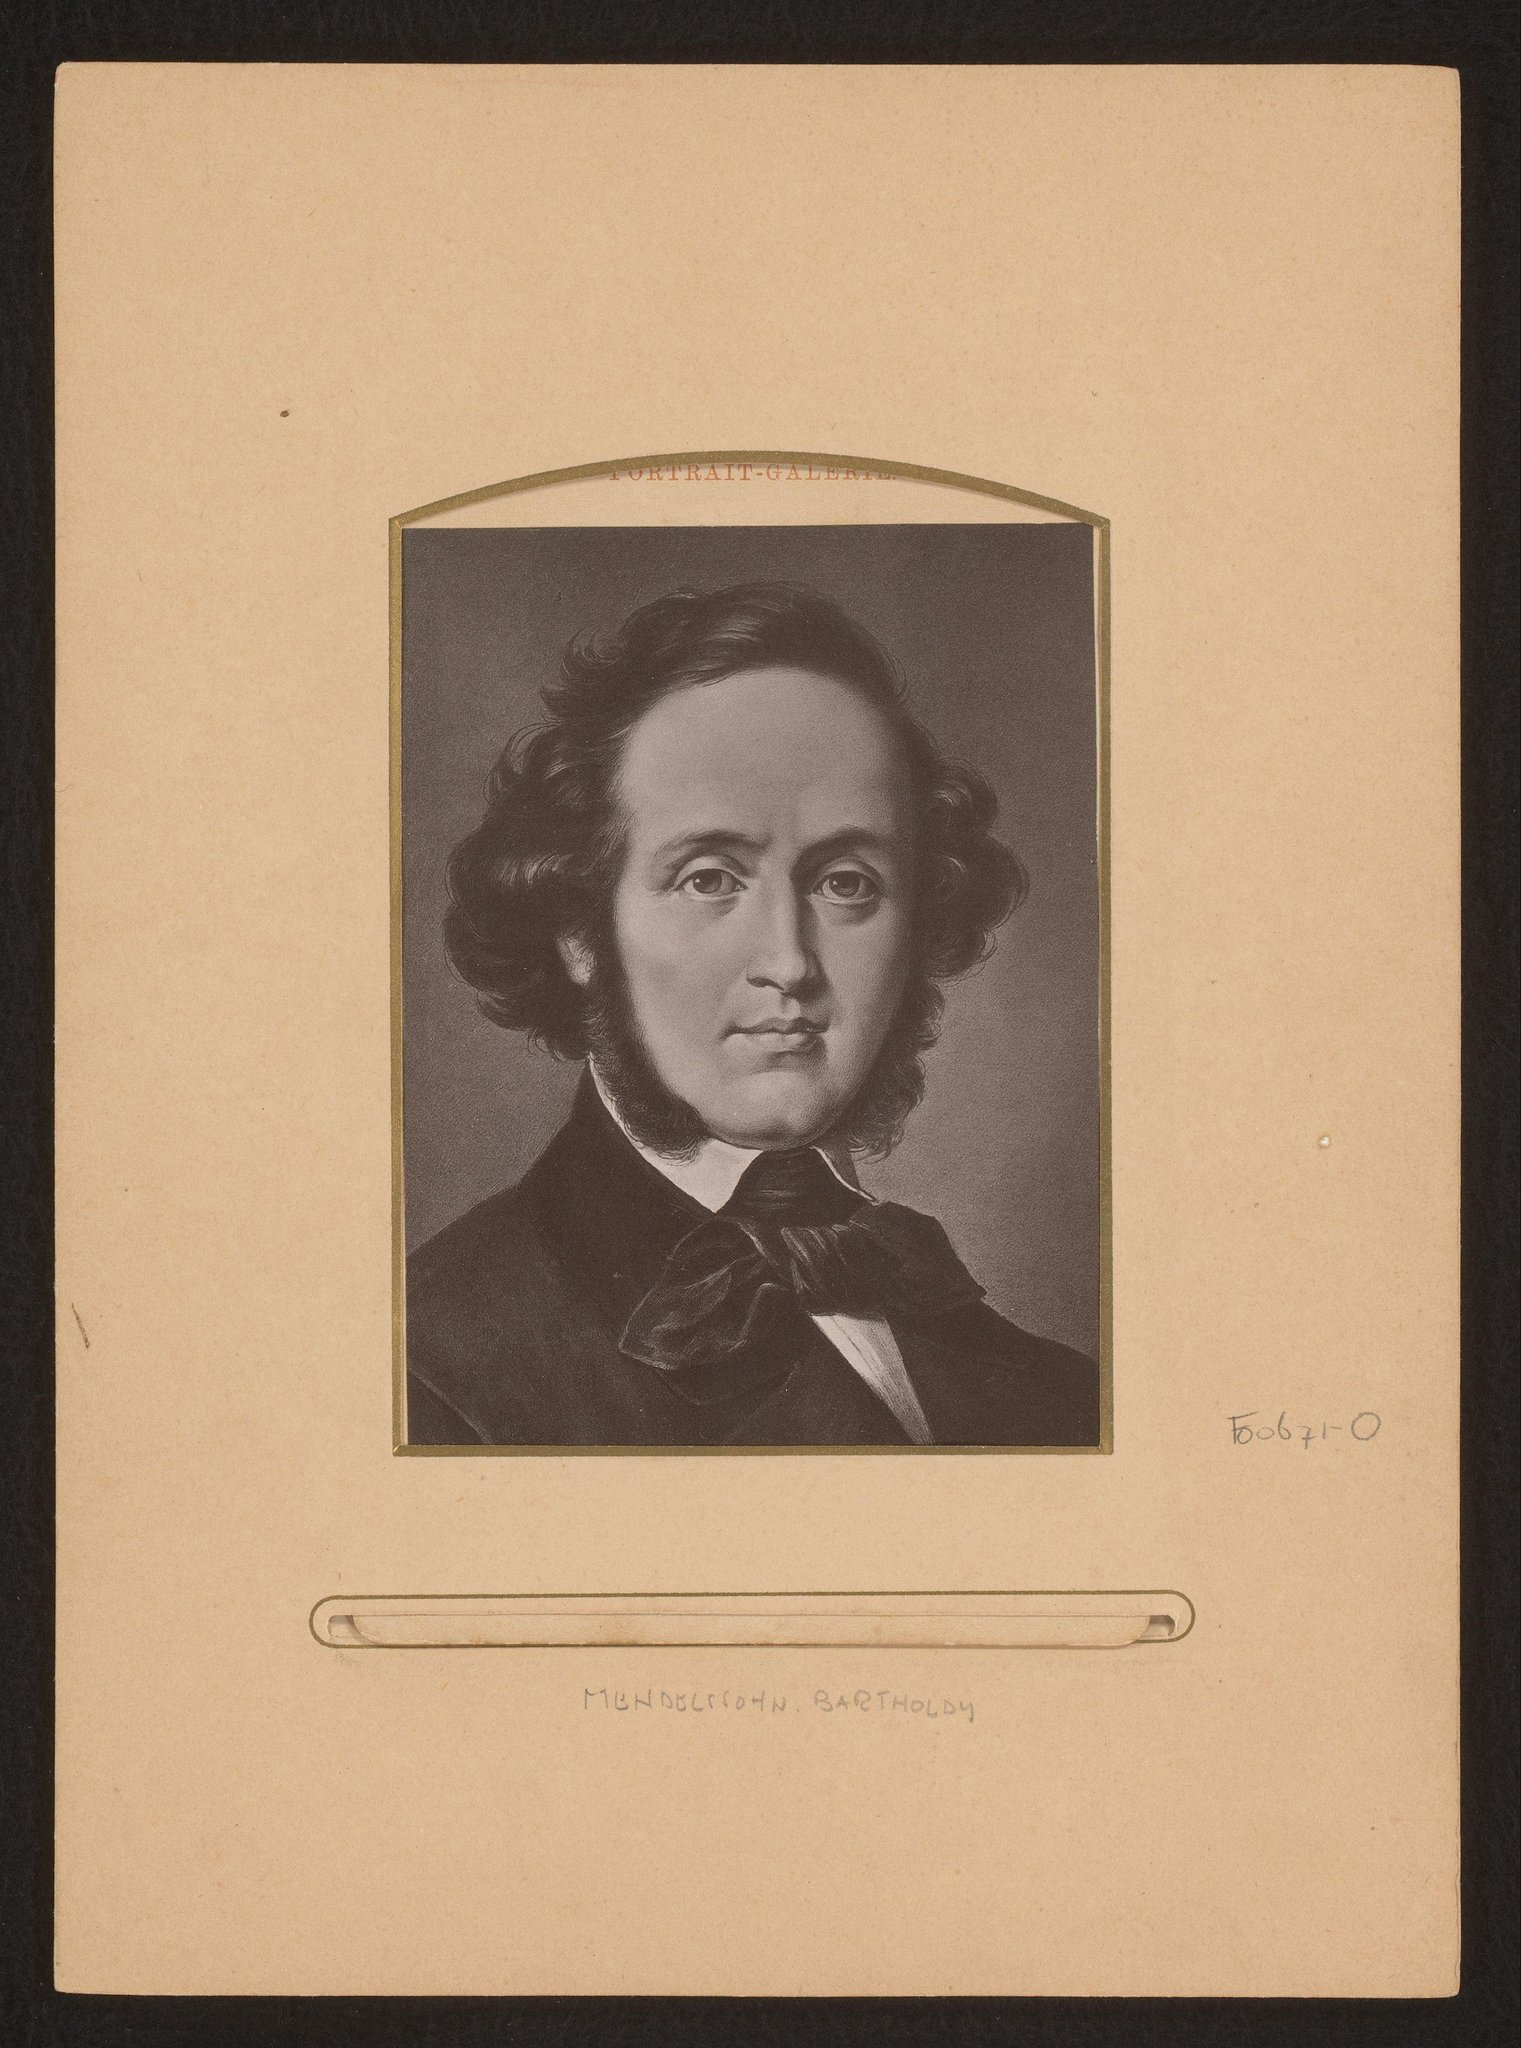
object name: photomechanical print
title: Reproductie van een geschilderd portret van Felix Mendelssohn Bartholdy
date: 1870-1900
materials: paper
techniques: photograph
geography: dresden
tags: historical persons, portrait of composer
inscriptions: inscription: ‘Mendelssohn - Bartholdy./ (15)/ Verlag von Gustav Lohse in Dresden.’, name: ‘Mendelssohn Bartholdy’